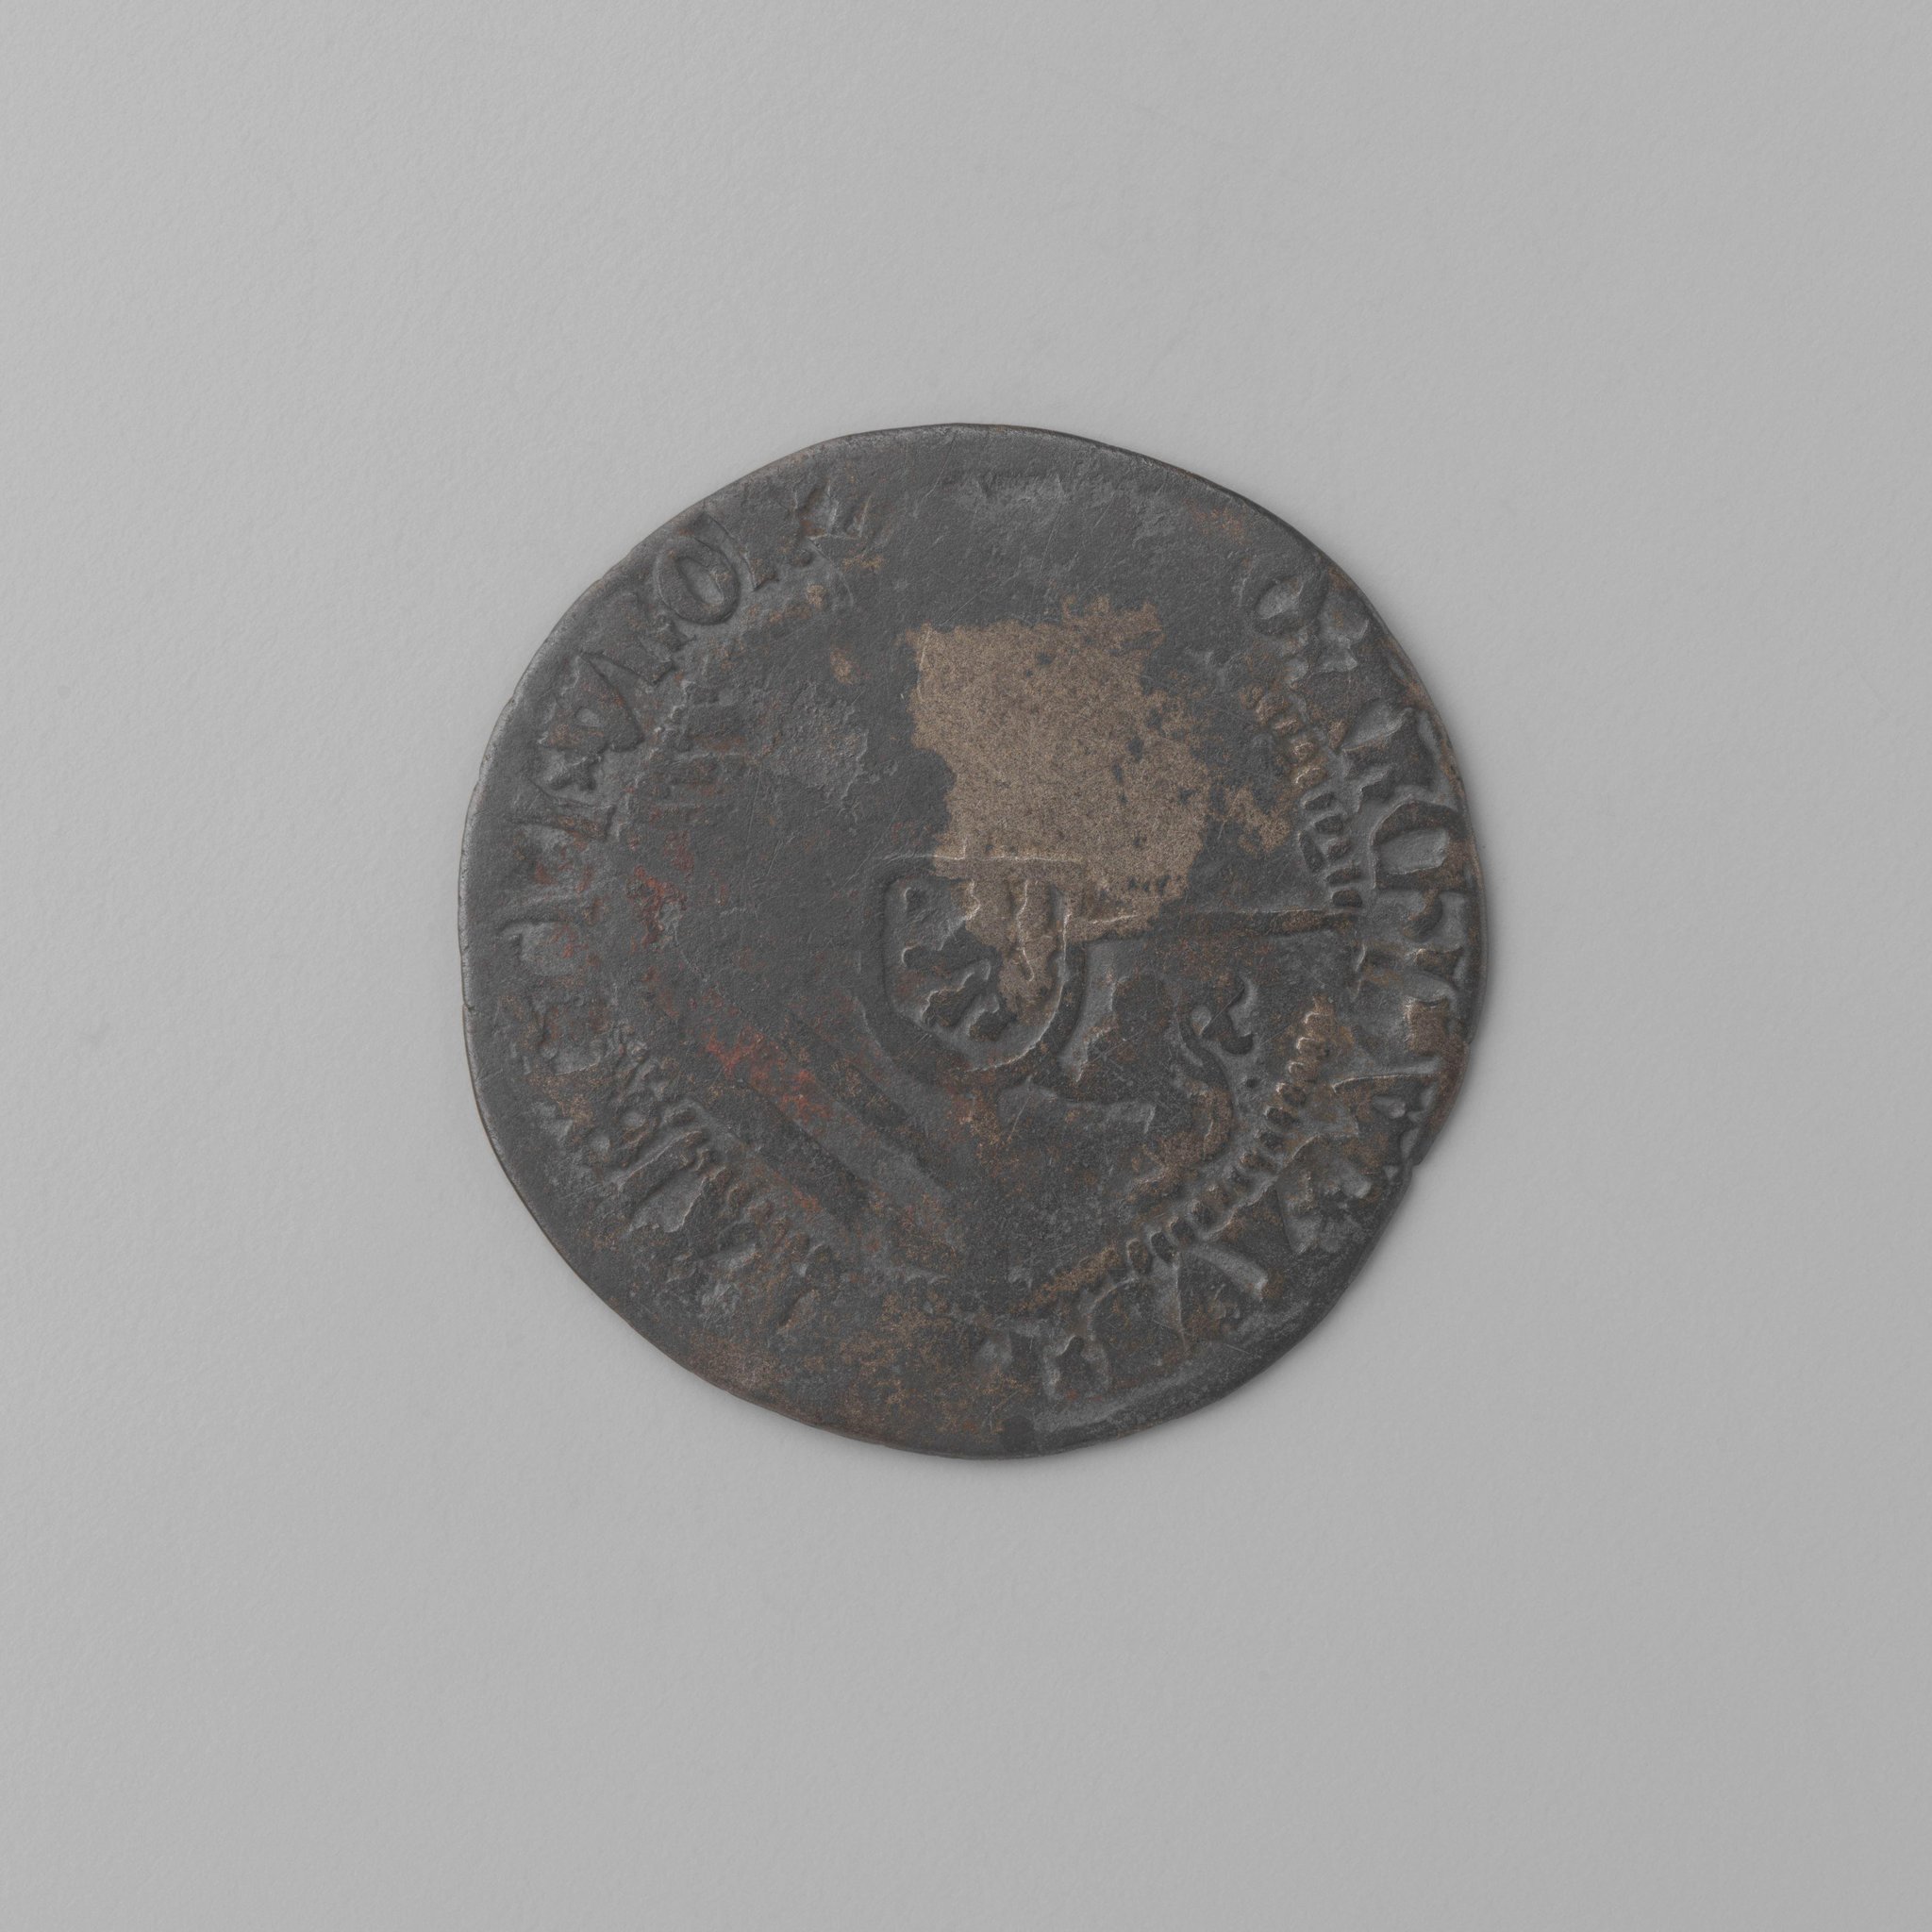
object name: coin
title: Groot van keizer Karel V, hertog van Brabant, 1509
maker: hertog van brabant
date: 1509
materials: silver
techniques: striking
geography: maastricht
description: Zilveren munt. Voorzijde: wapen. Keerzijde: lang versierd kruis, in het hart ster, in de hoeken afwiosselend een lelie en een leeuw.